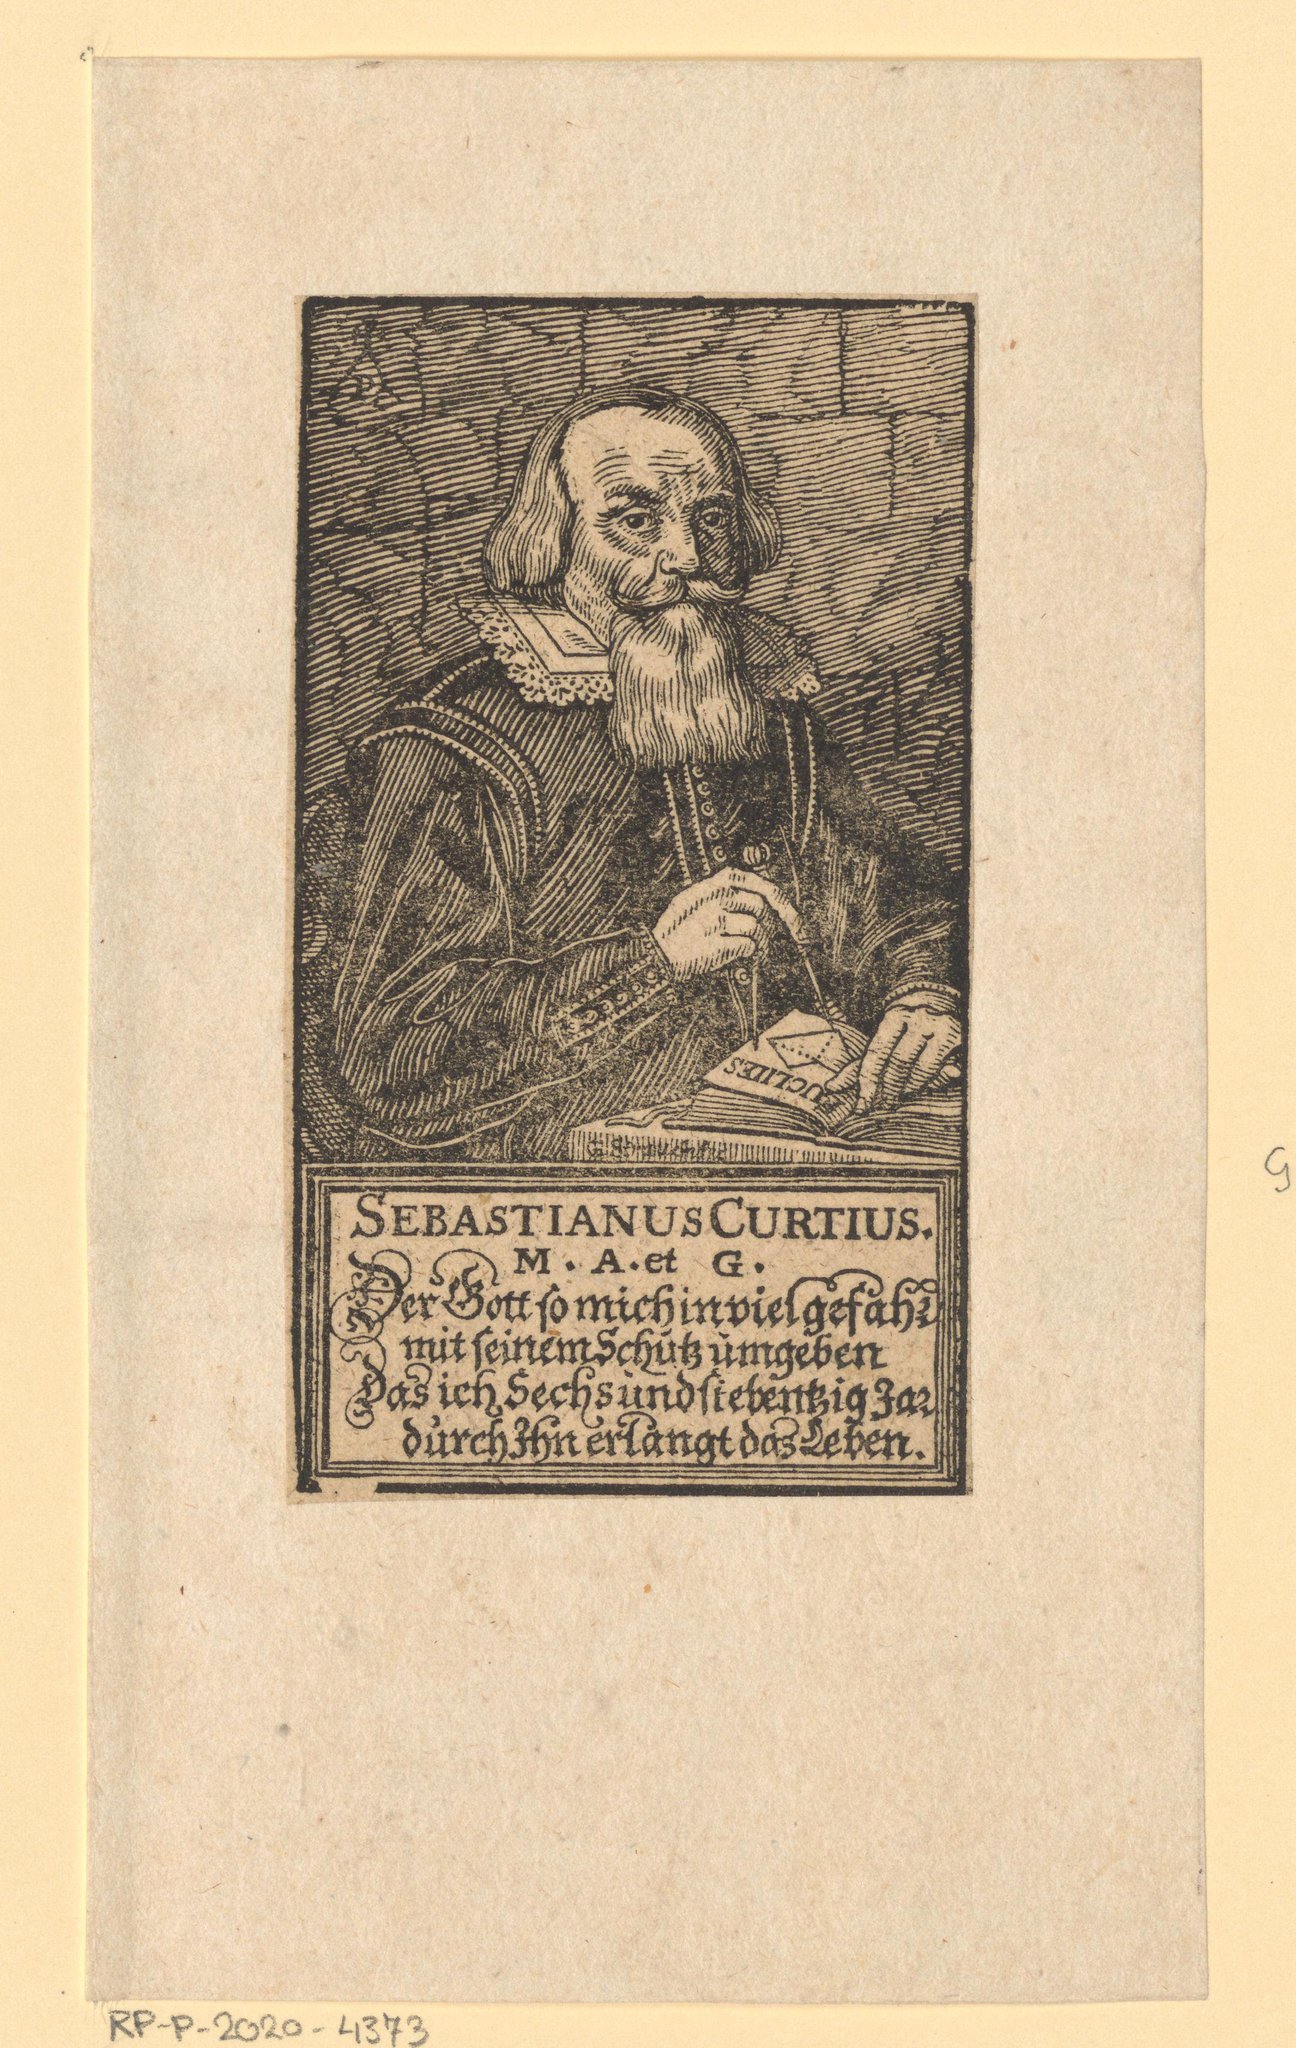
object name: print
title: Portret van Sebastianus Curtius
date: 1623-1675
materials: paper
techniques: woodcut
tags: historical persons